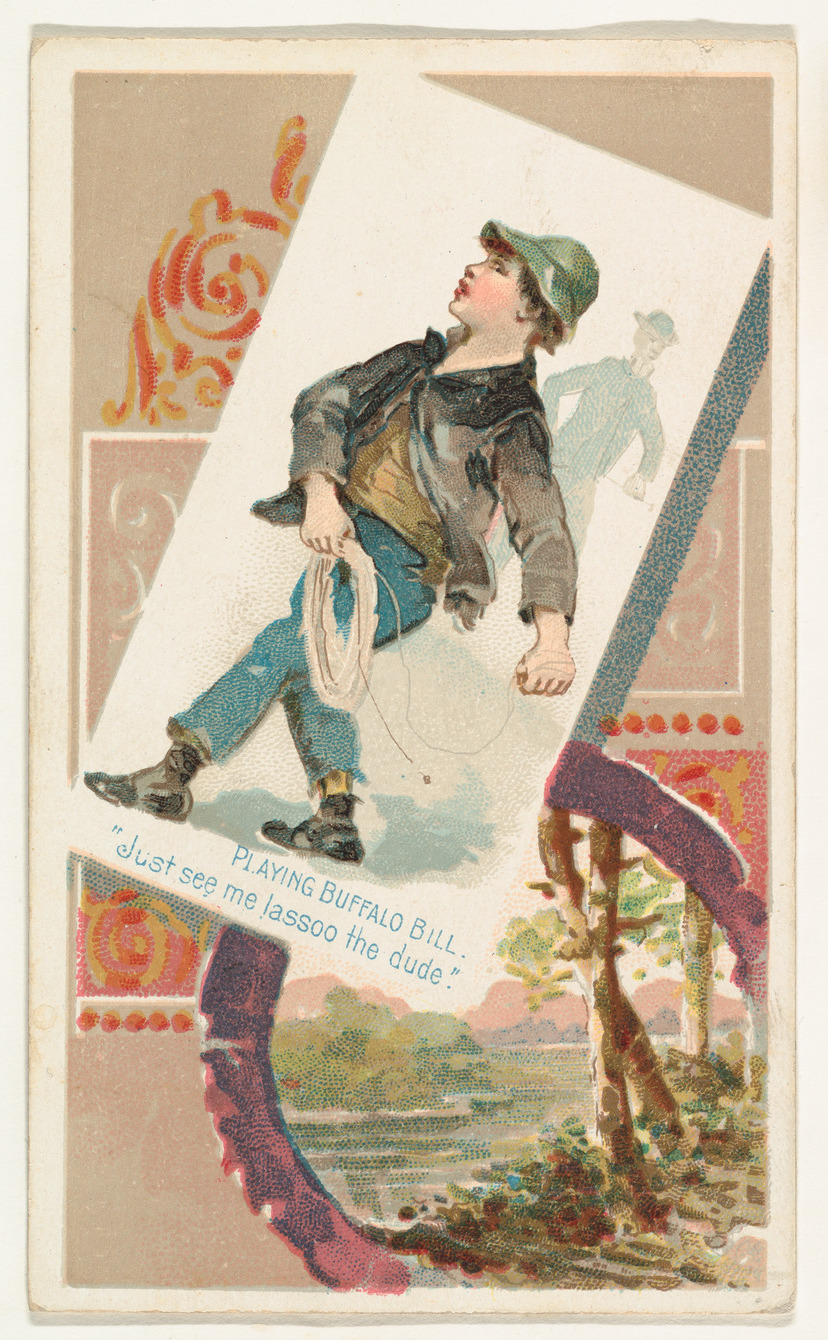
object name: print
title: Playing Buffalo Bill, "Just see me lassoo the dude," from the Terrors of America set (N136) issued by Duke Sons & Co. to promote Honest Long Cut Tobacco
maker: w. duke, sons & co.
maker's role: publisher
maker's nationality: american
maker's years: 1870-1920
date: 1888-1889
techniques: color lithograph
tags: boys,profiles